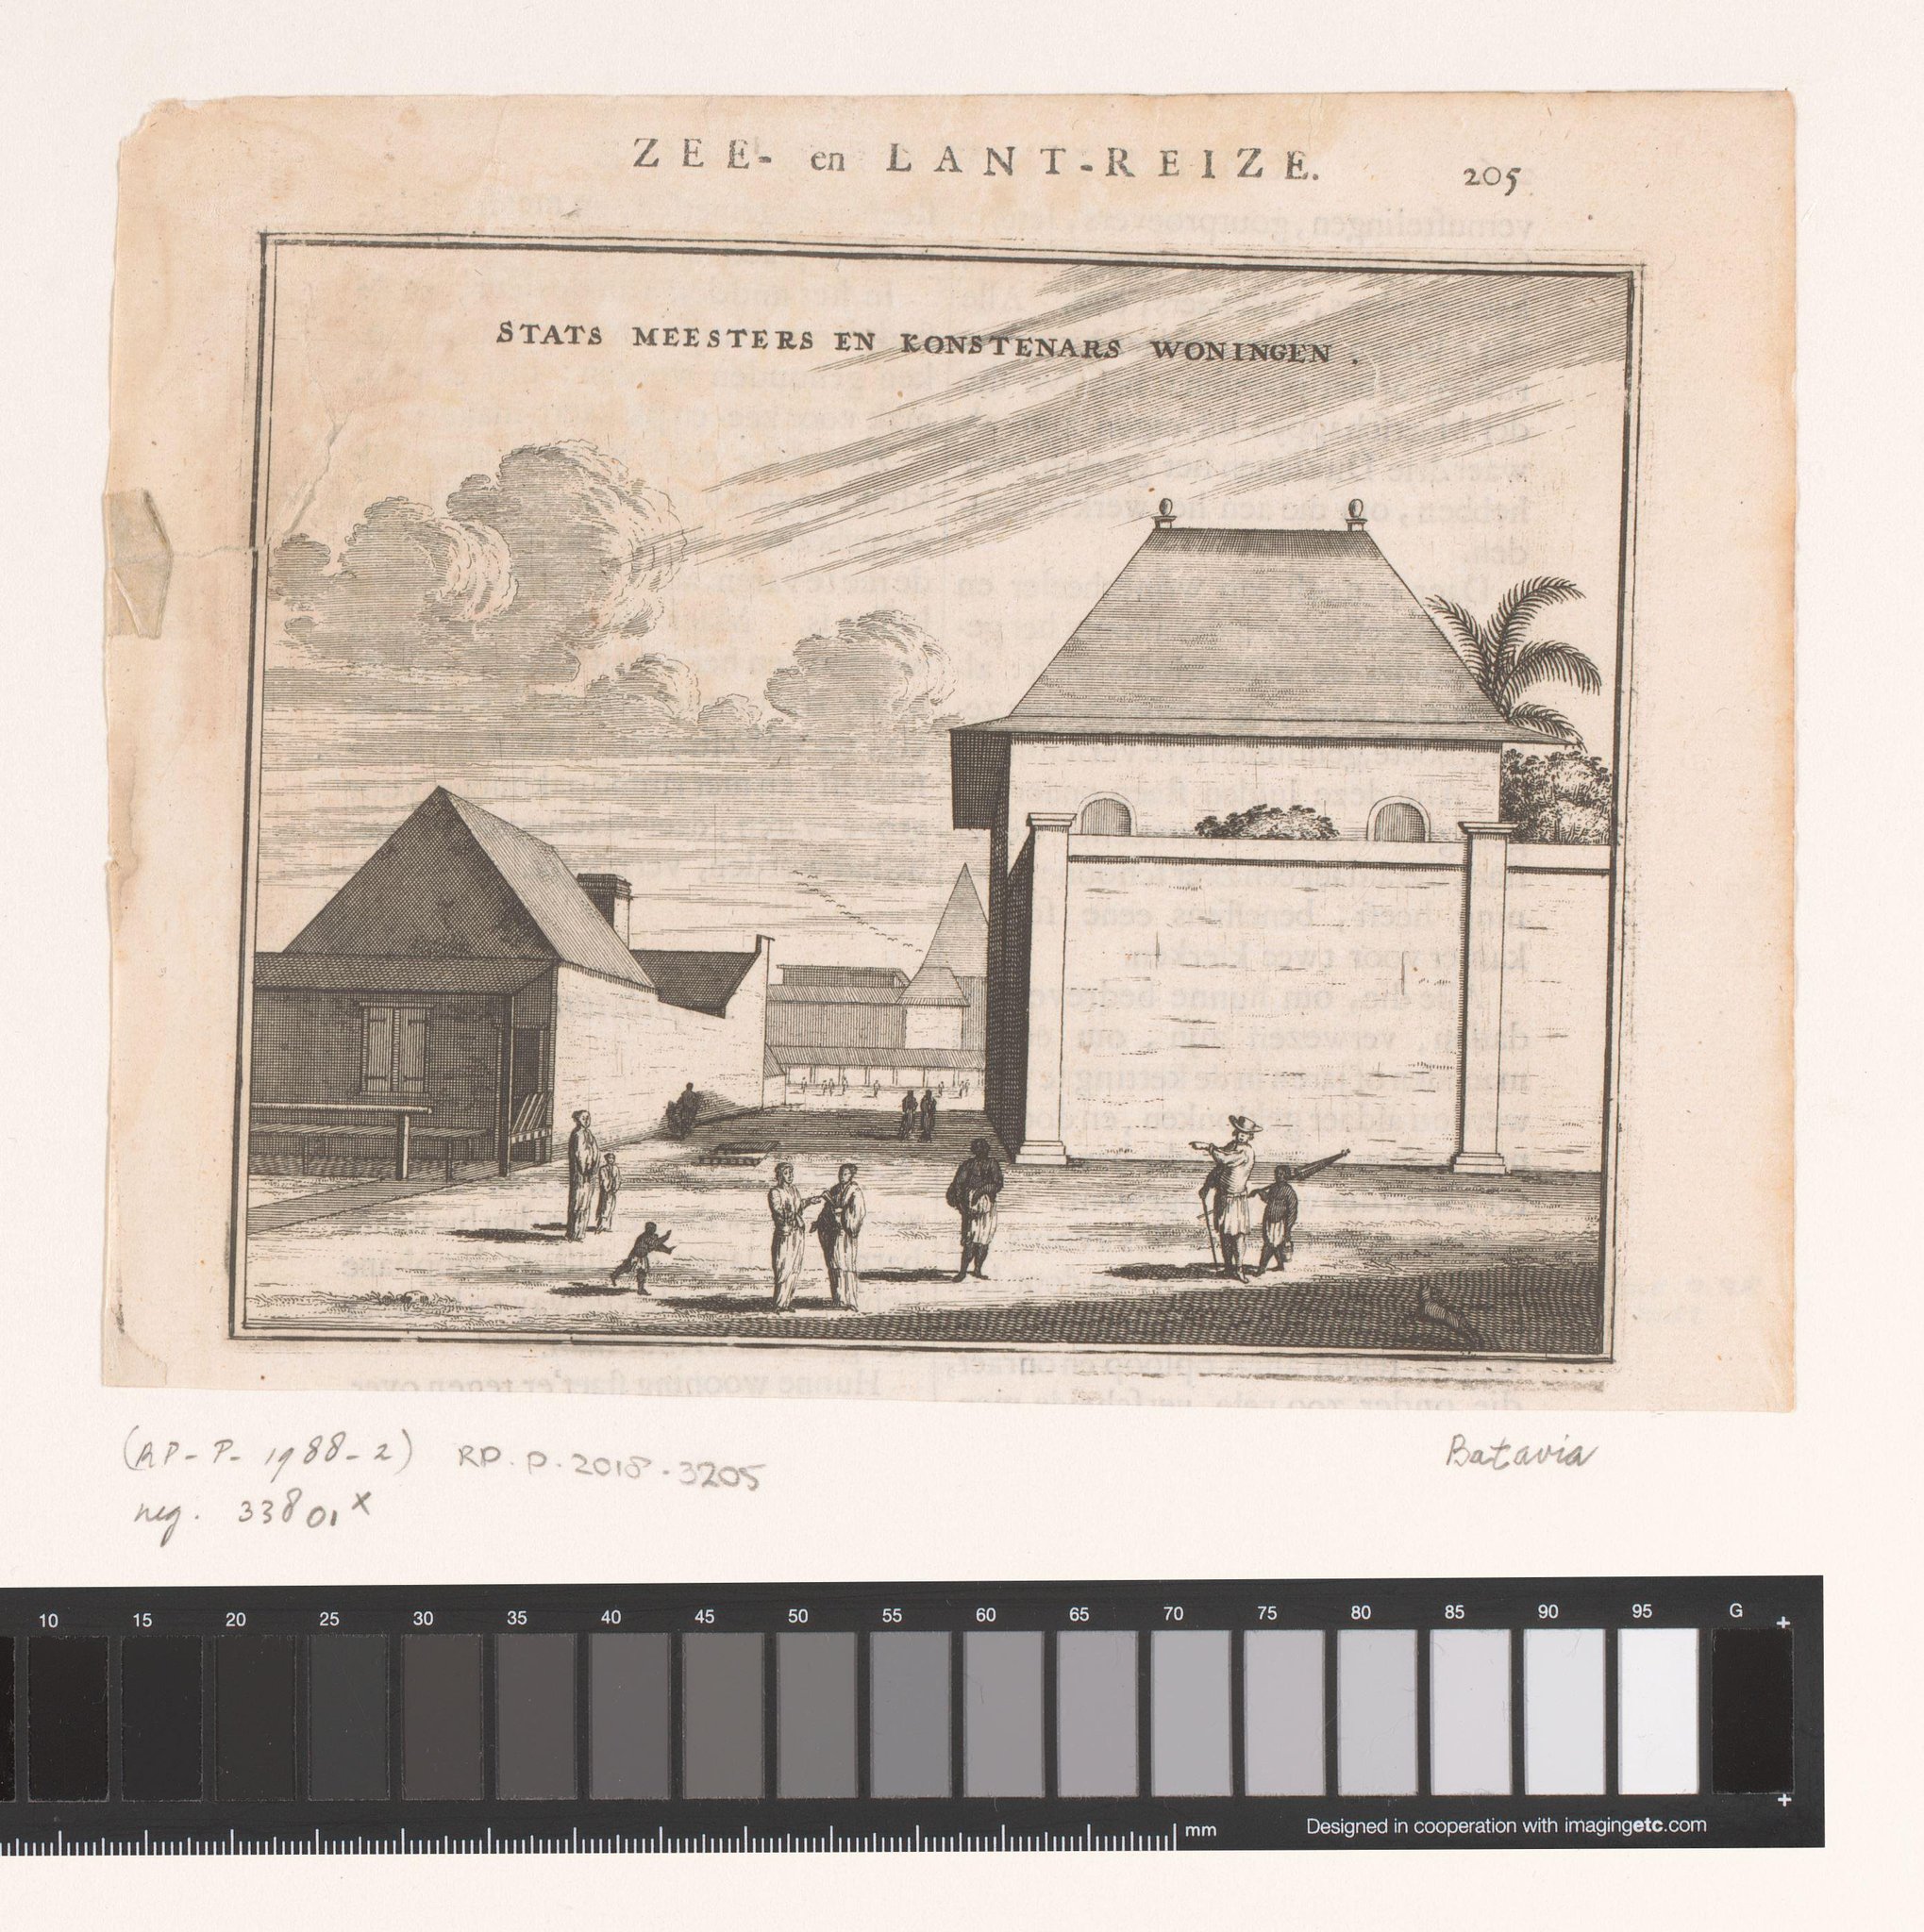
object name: print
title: Stats meesters en konstenars woningen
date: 1682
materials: paper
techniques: engraving, etching, letterpress printing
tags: urban housing, batavia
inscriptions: collector's mark: Lugt 2760, collector's mark: Lugt 2228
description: Prent uit: Nieuhof, Joan. Joan Nieuhofs zee en lant-reize, door verscheide Gewesten van Oostindien (...). Amsterdam: Jacob van Meurs, 1682, p. 205.